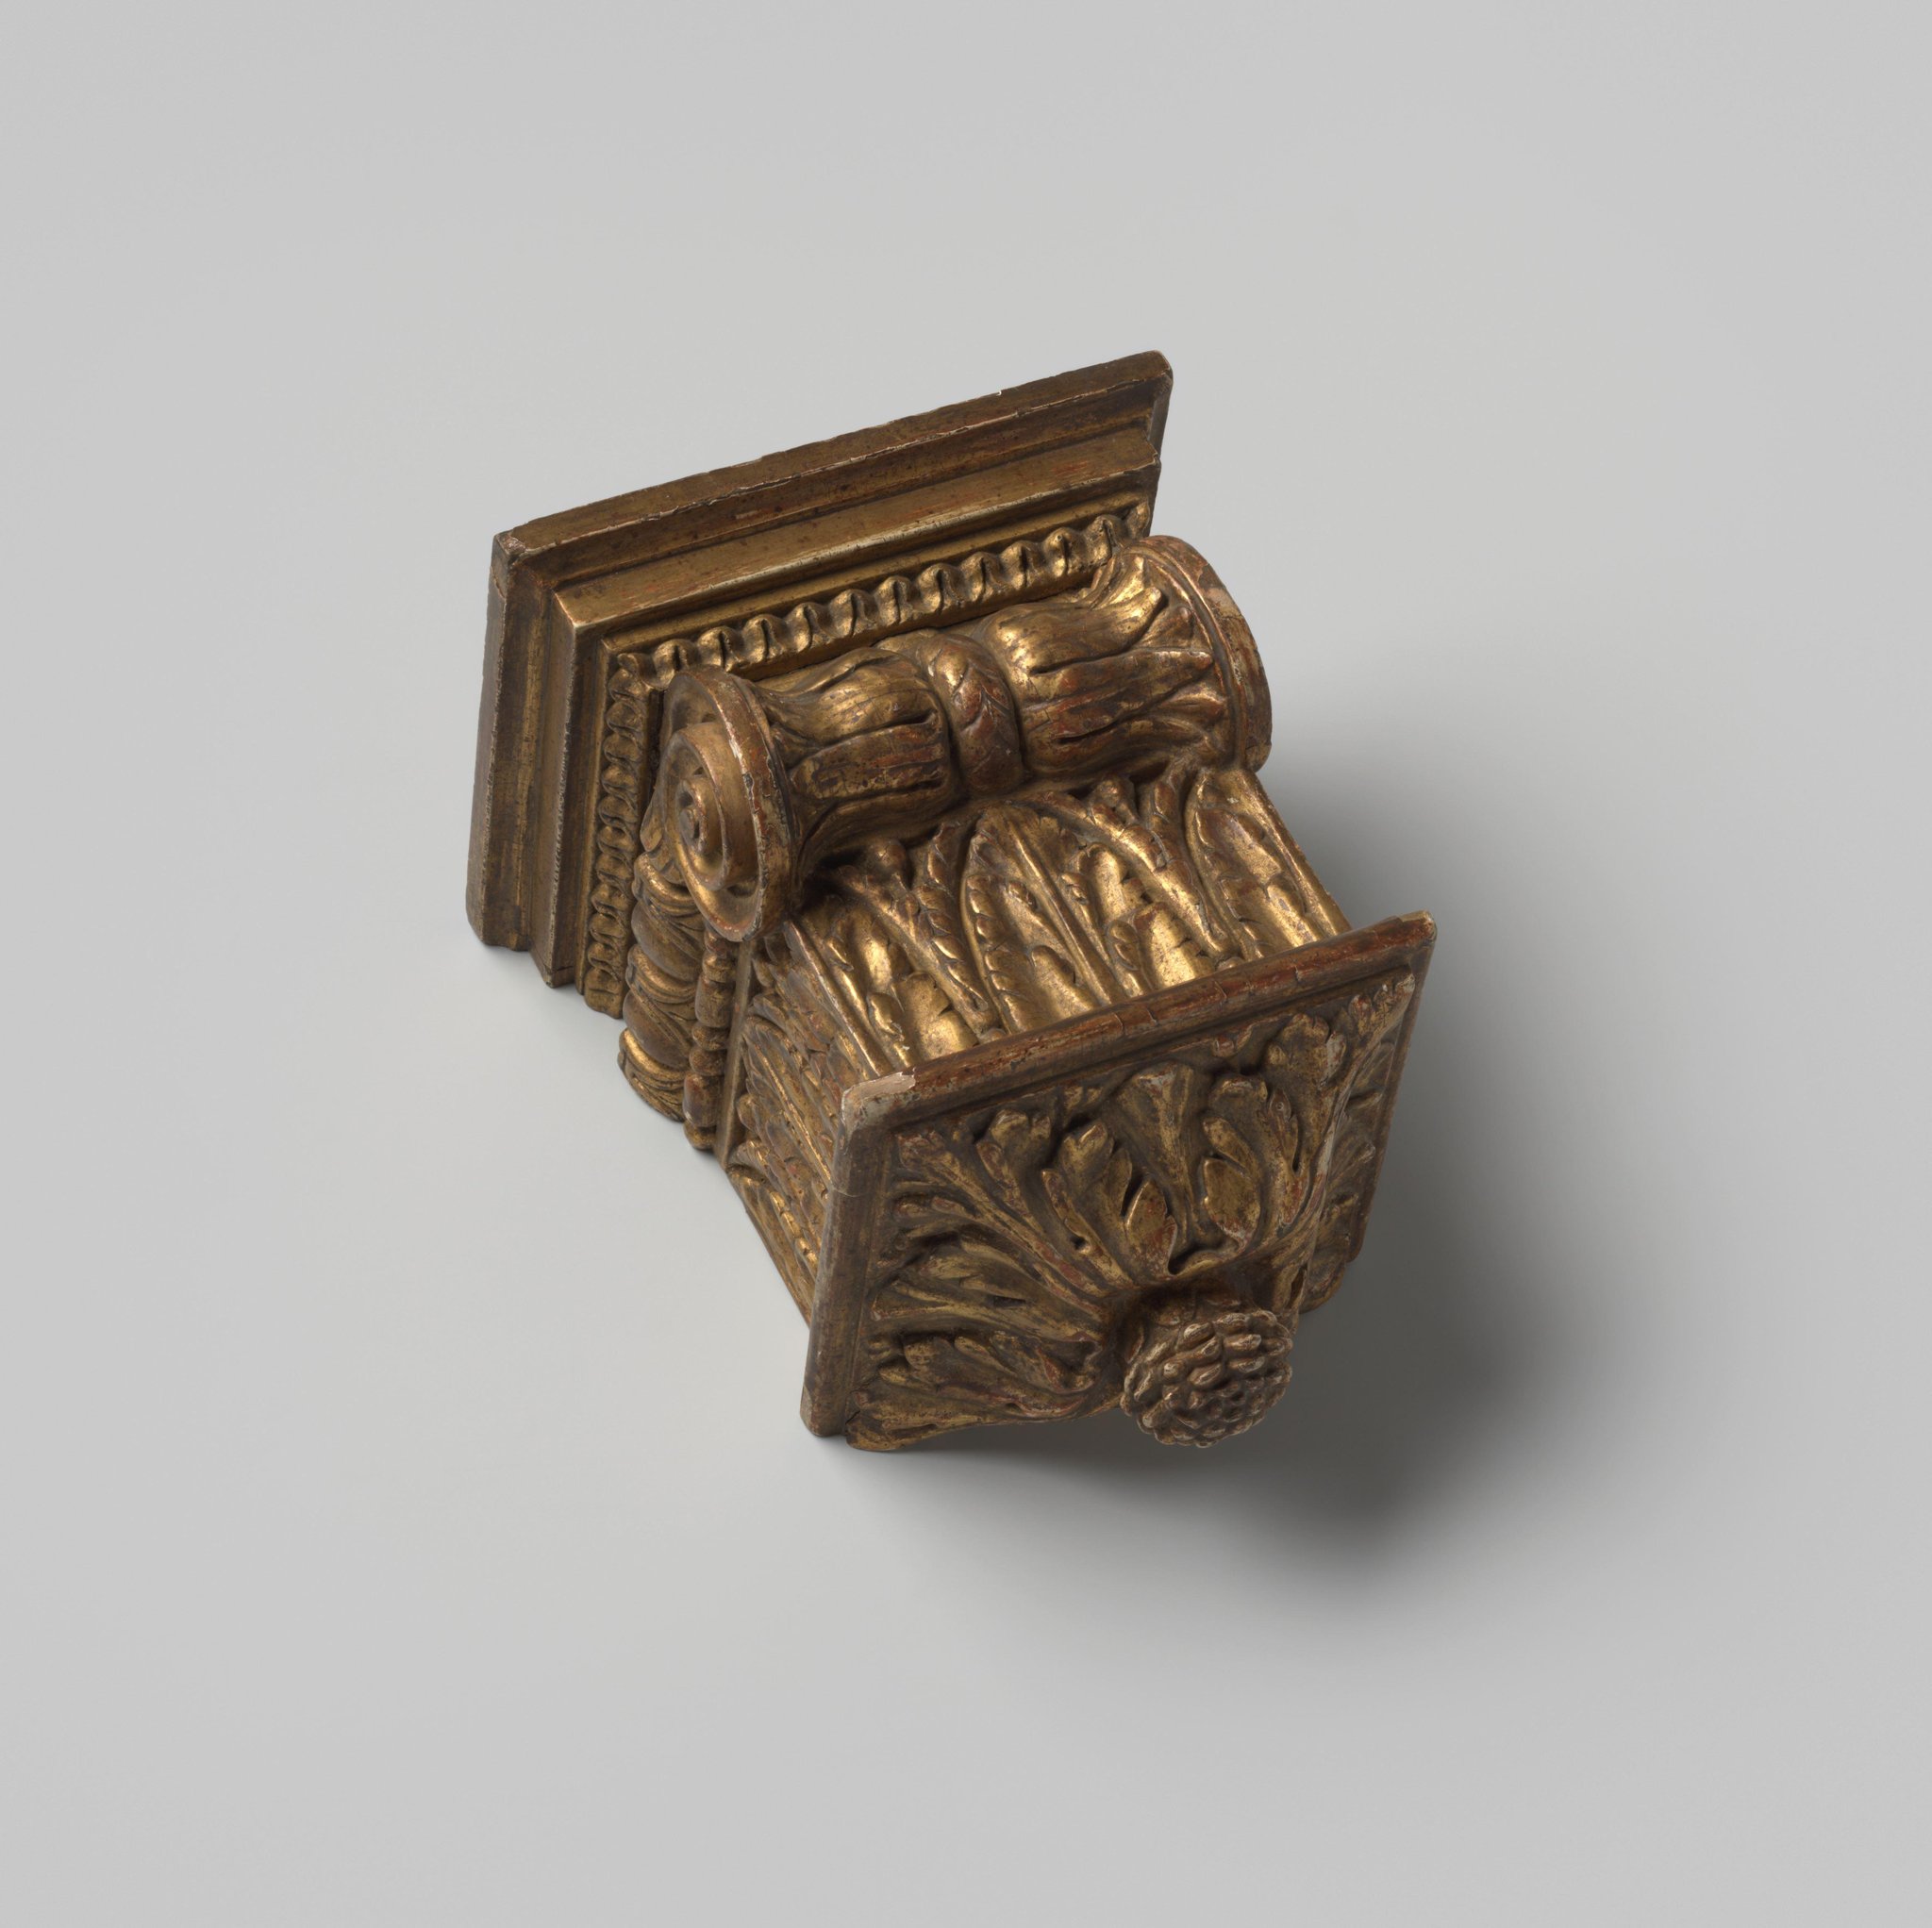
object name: architectural element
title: Console van eikenhout en palmhout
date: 1400-1499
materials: wood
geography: italy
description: Console van eike- en palmhout. Het lichaam is een kubus, in reliëf besneden met acanthusblad en eindigend in een kapiteel van de Ionische orde, versierd met bladwerk en een forse eierlijst, waaronder een parellijst. De kubus staat op een uitspringende basis, welke aan de onderzijde taps toelopende acanthusbladeren vertoont, eindigend in een hangende granaatappel. De abacus bestaat uit drie geledingen, waarvan de onderste versierd is met een cumamotief.